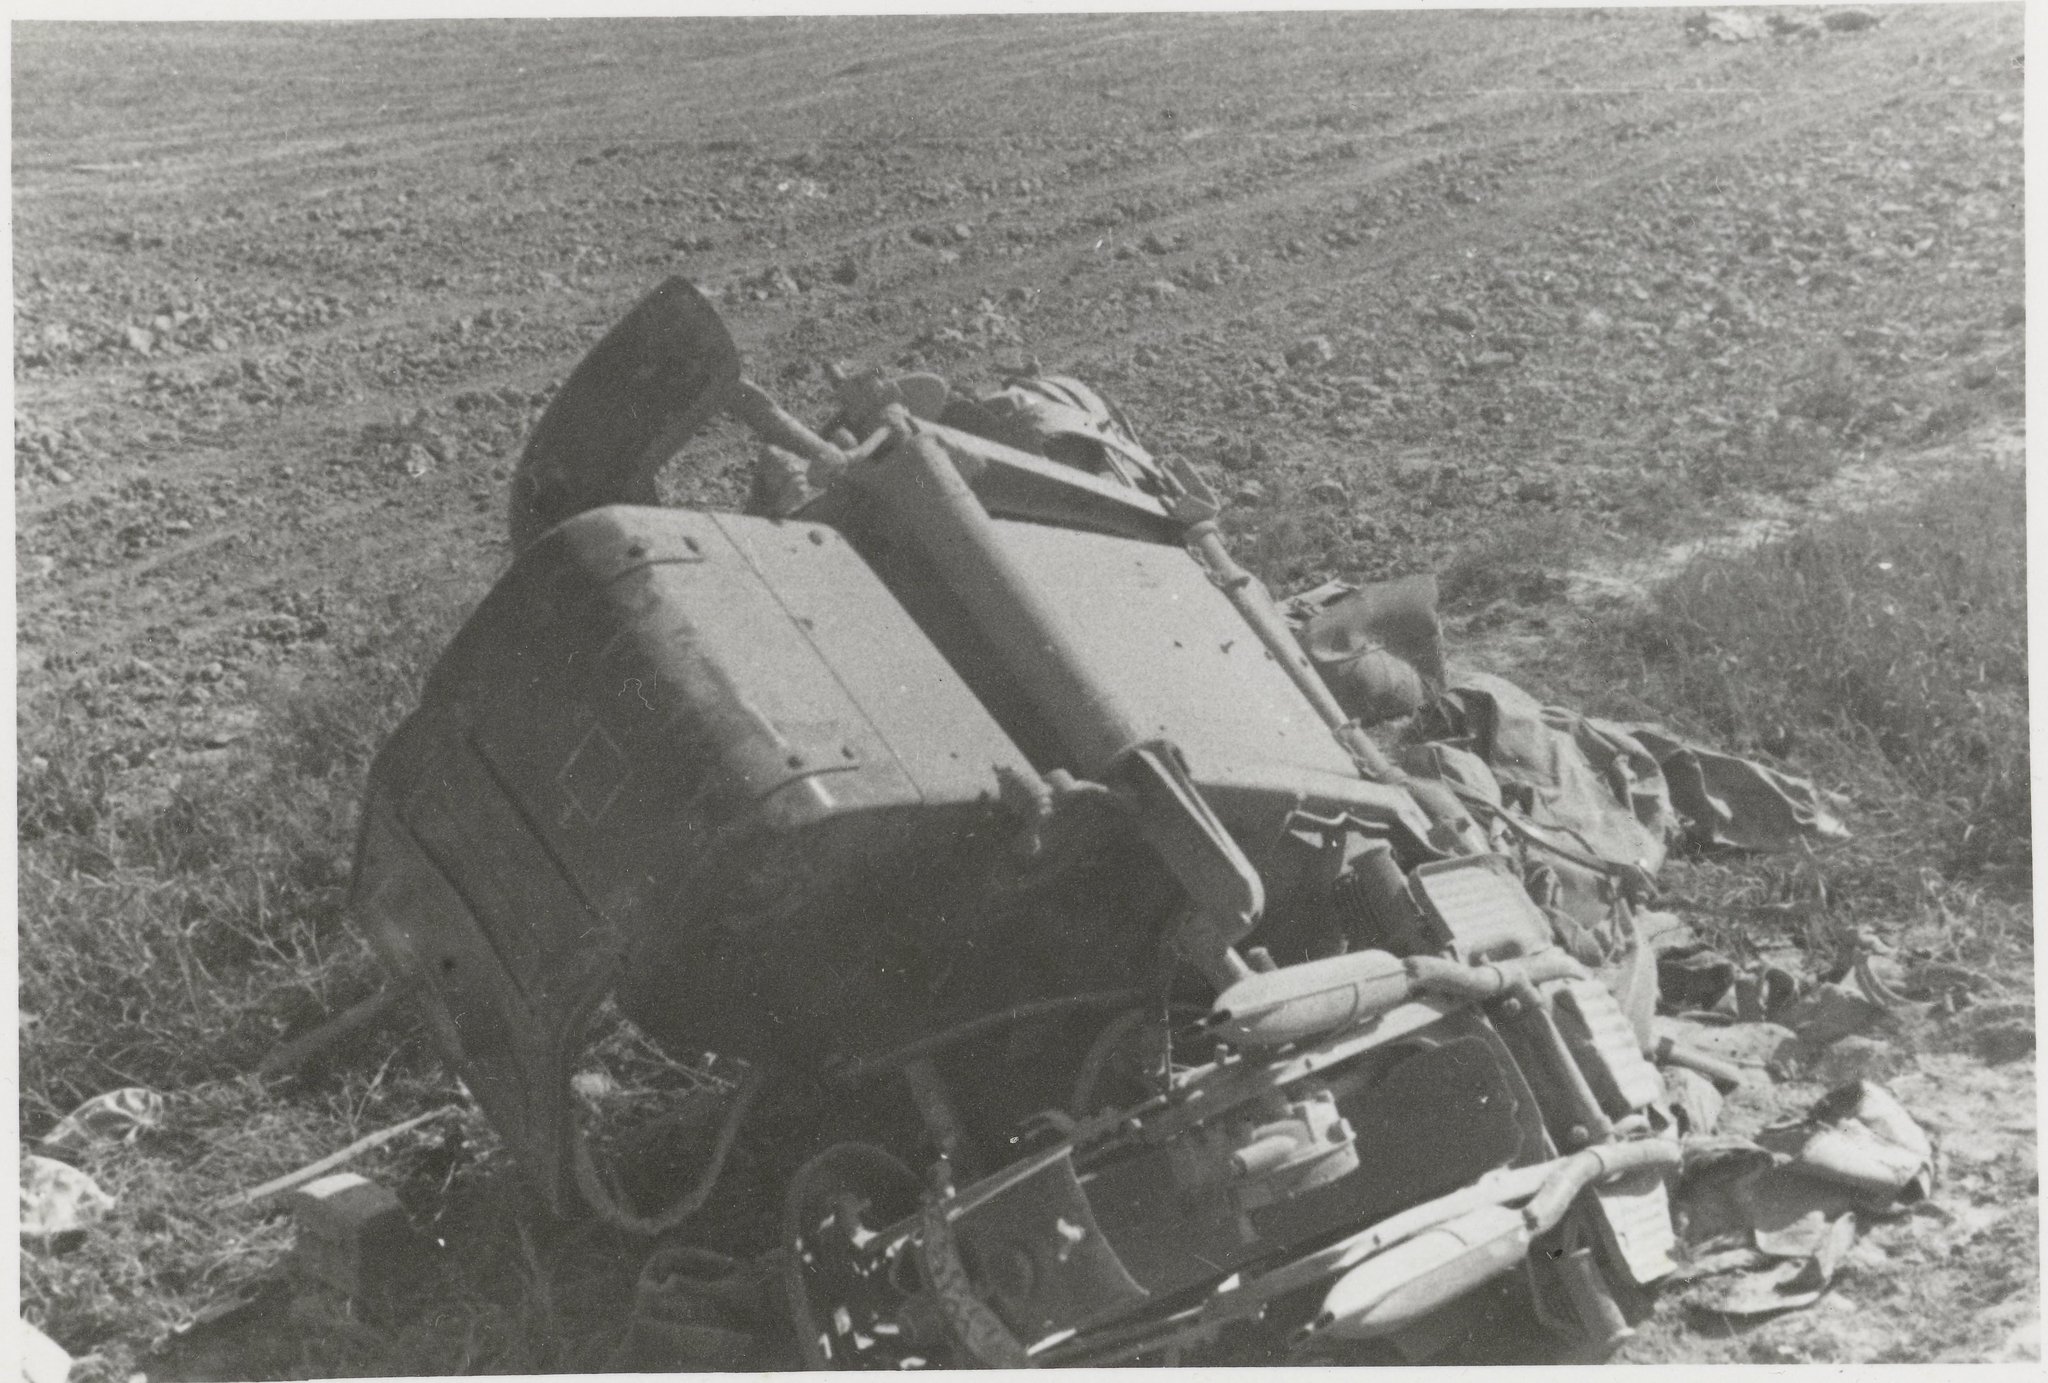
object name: photograph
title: Foto behorend bij album Kriegserinnerungen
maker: Anonymous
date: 1940-1945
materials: photographic support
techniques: gelatin silver print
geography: germany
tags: netherlands, germany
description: Foto behorend bij album 'Kriegserinnerungen'.